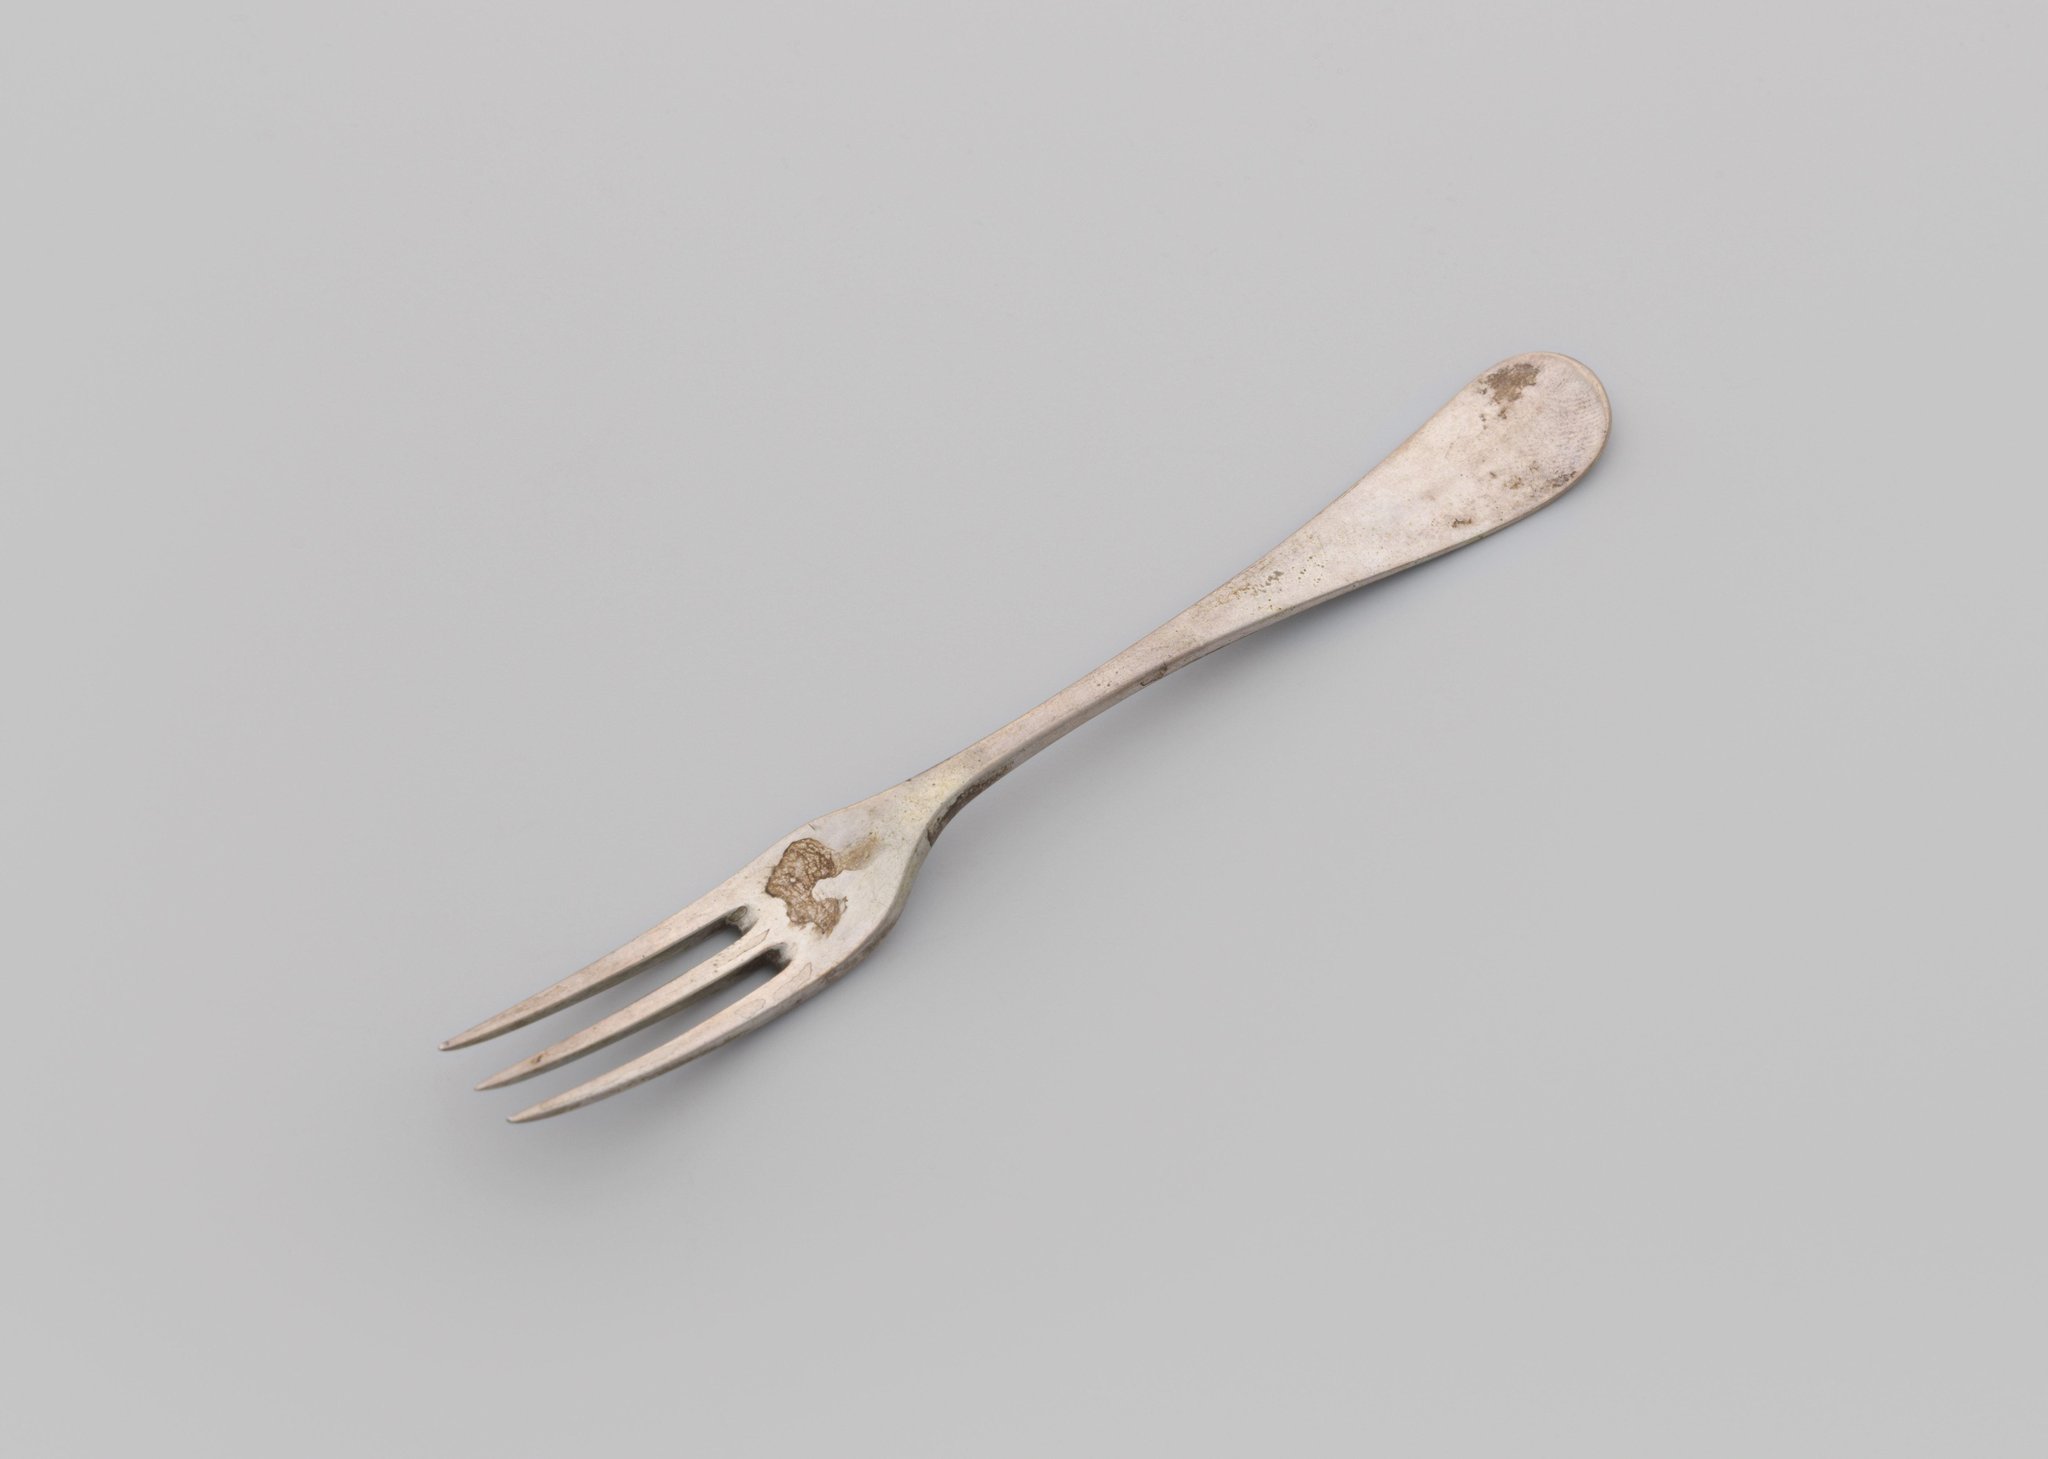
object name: fork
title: Vork van zilver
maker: a. keun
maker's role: silversmith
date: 1821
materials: silver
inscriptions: mark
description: Vork van zilver, met drie tanden. De platte, gebogen steel verbreedt zich naar het afgeronde uiteinde.